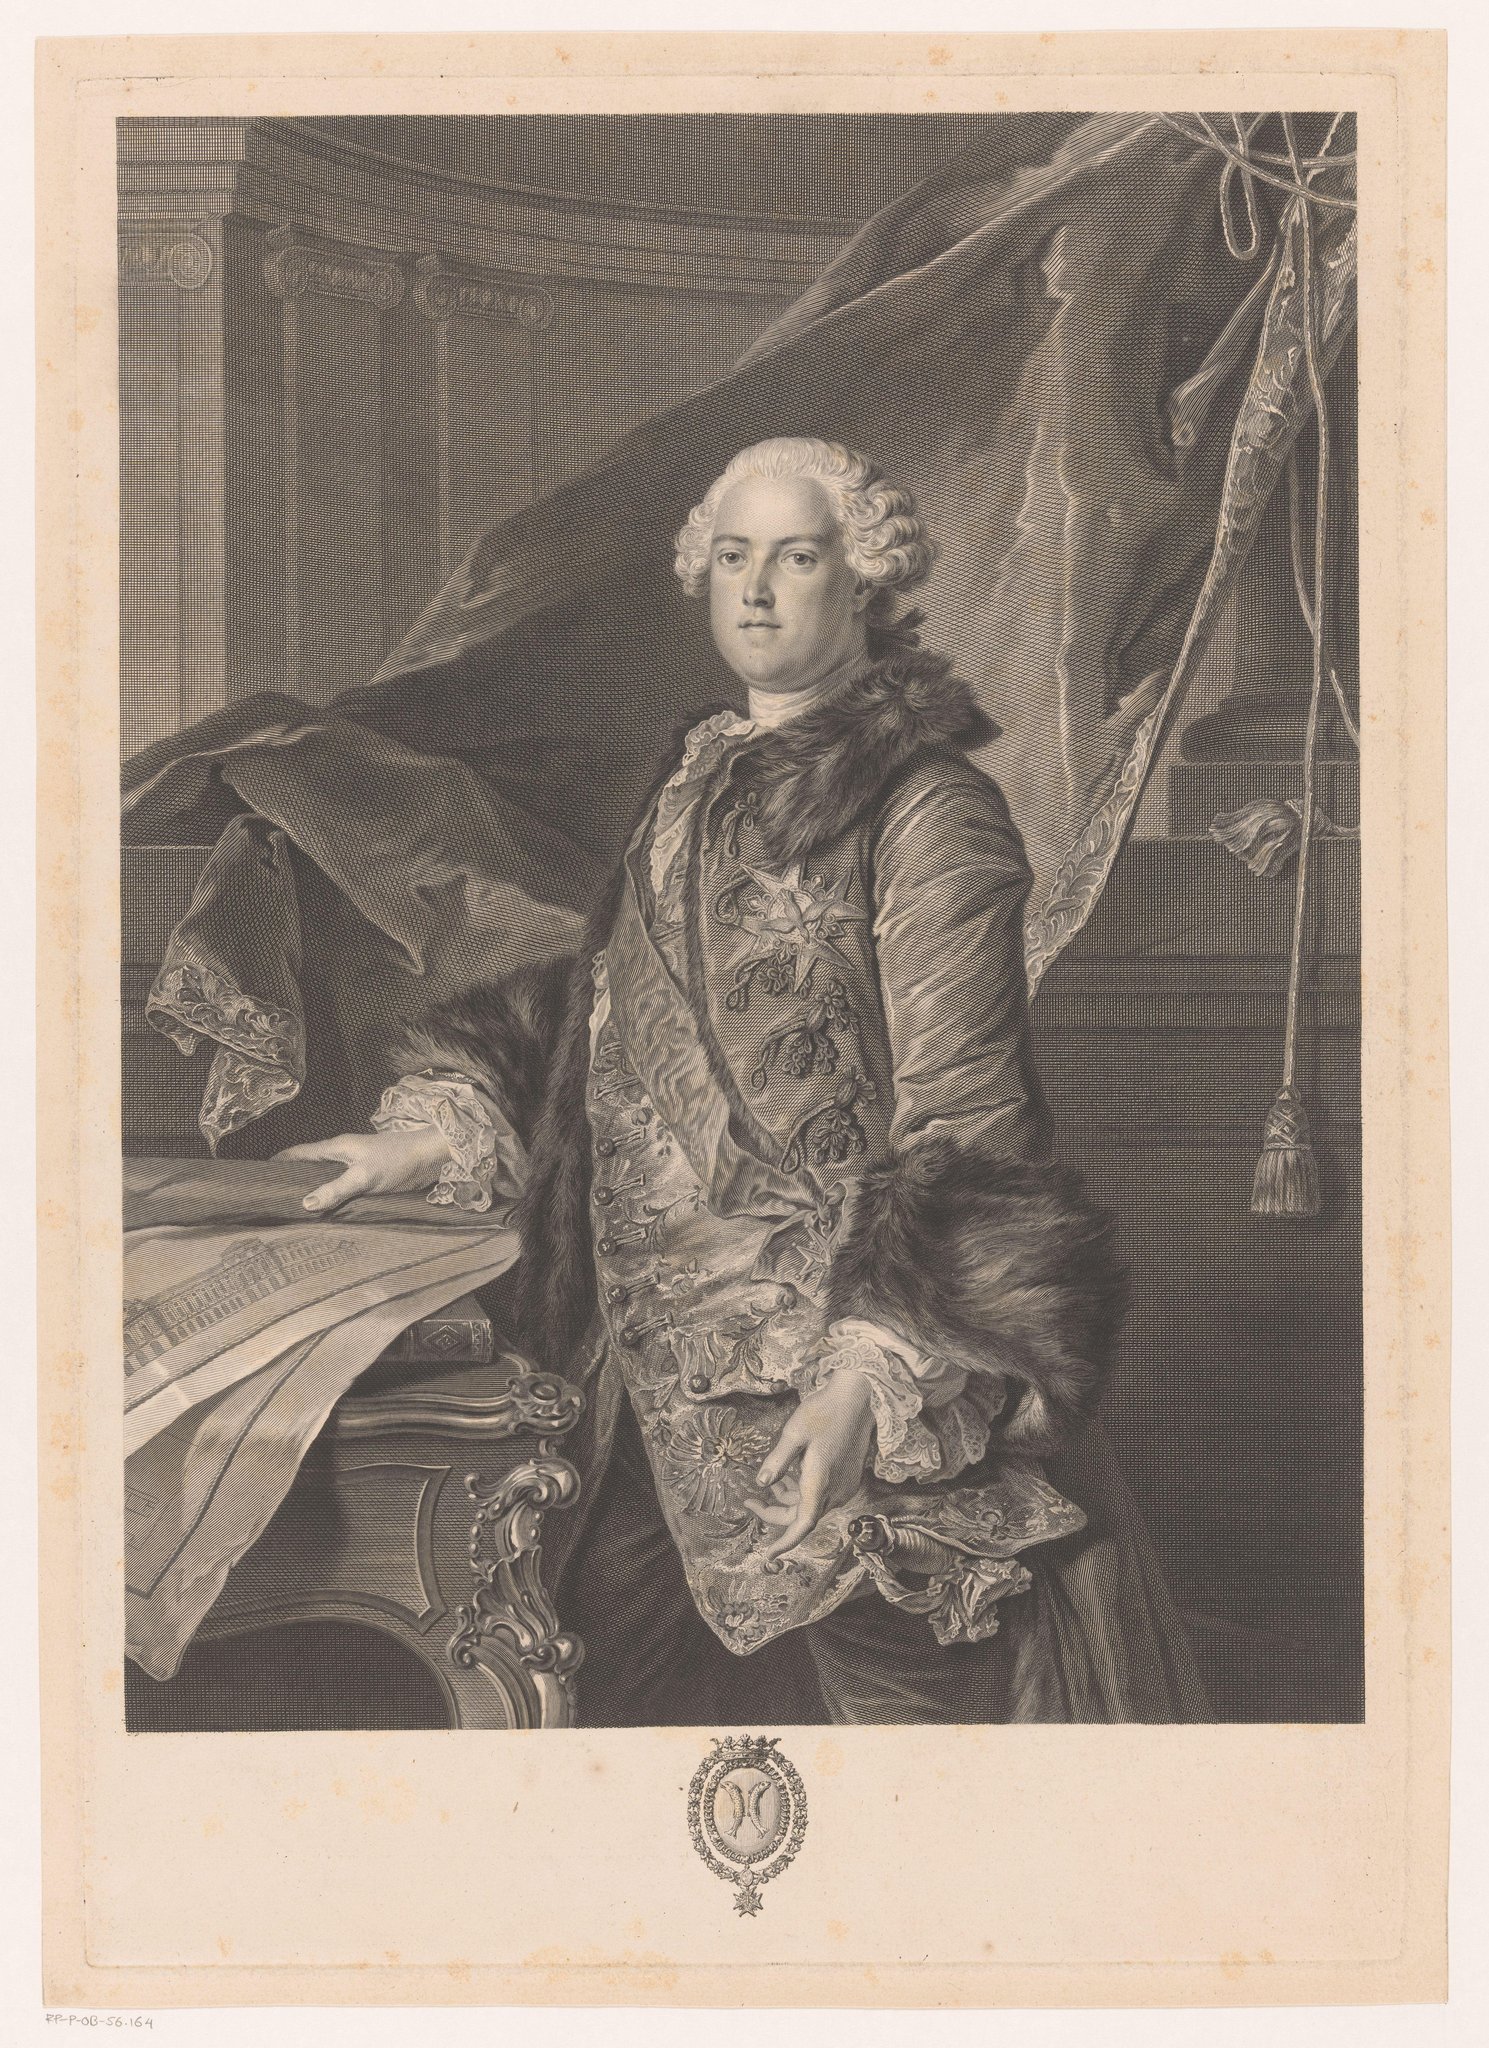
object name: print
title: Portret van Abel François Poisson, marquis de Marigny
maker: johann georg wille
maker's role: draughtsman, print maker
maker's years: 1715-1808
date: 1761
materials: paper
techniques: engraving, etching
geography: france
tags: abel françois poisson de vandières (marquis de marigny), historical persons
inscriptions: collector's mark: Lugt 240